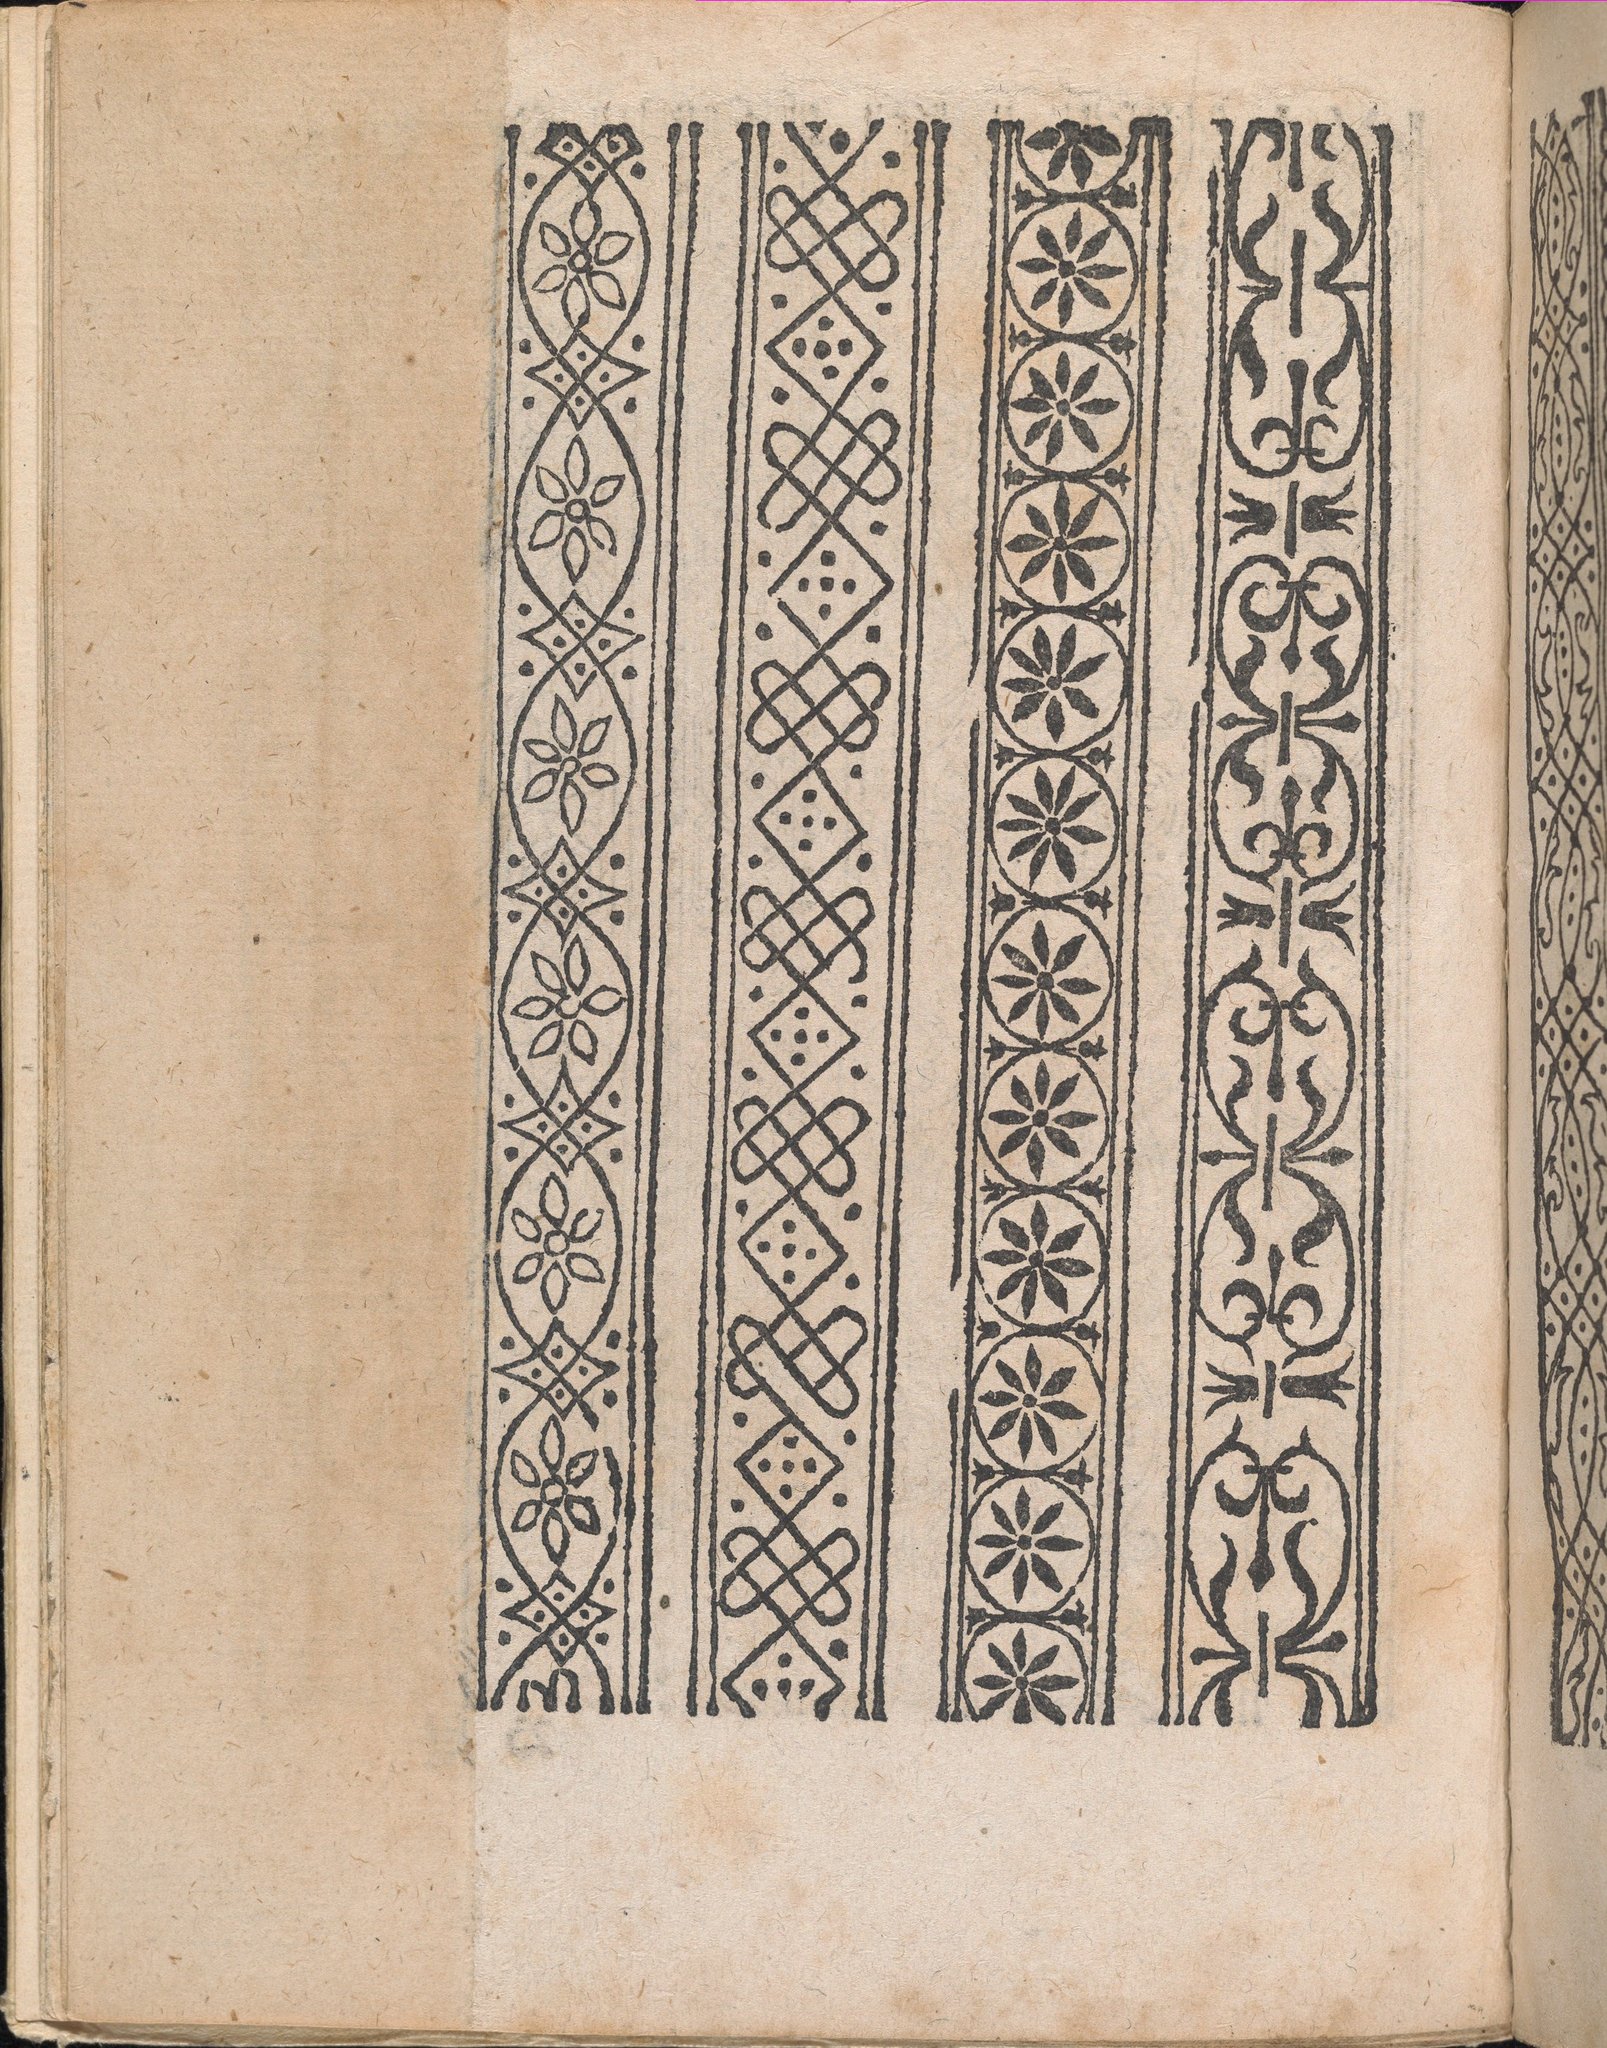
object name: book print ornament architecture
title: Modelbuch aller Art Nehens vn Stickens (Page 7v)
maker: christian egenolff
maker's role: publisher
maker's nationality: german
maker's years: 1502-1555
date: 1535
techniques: woodcut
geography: germany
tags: ornament